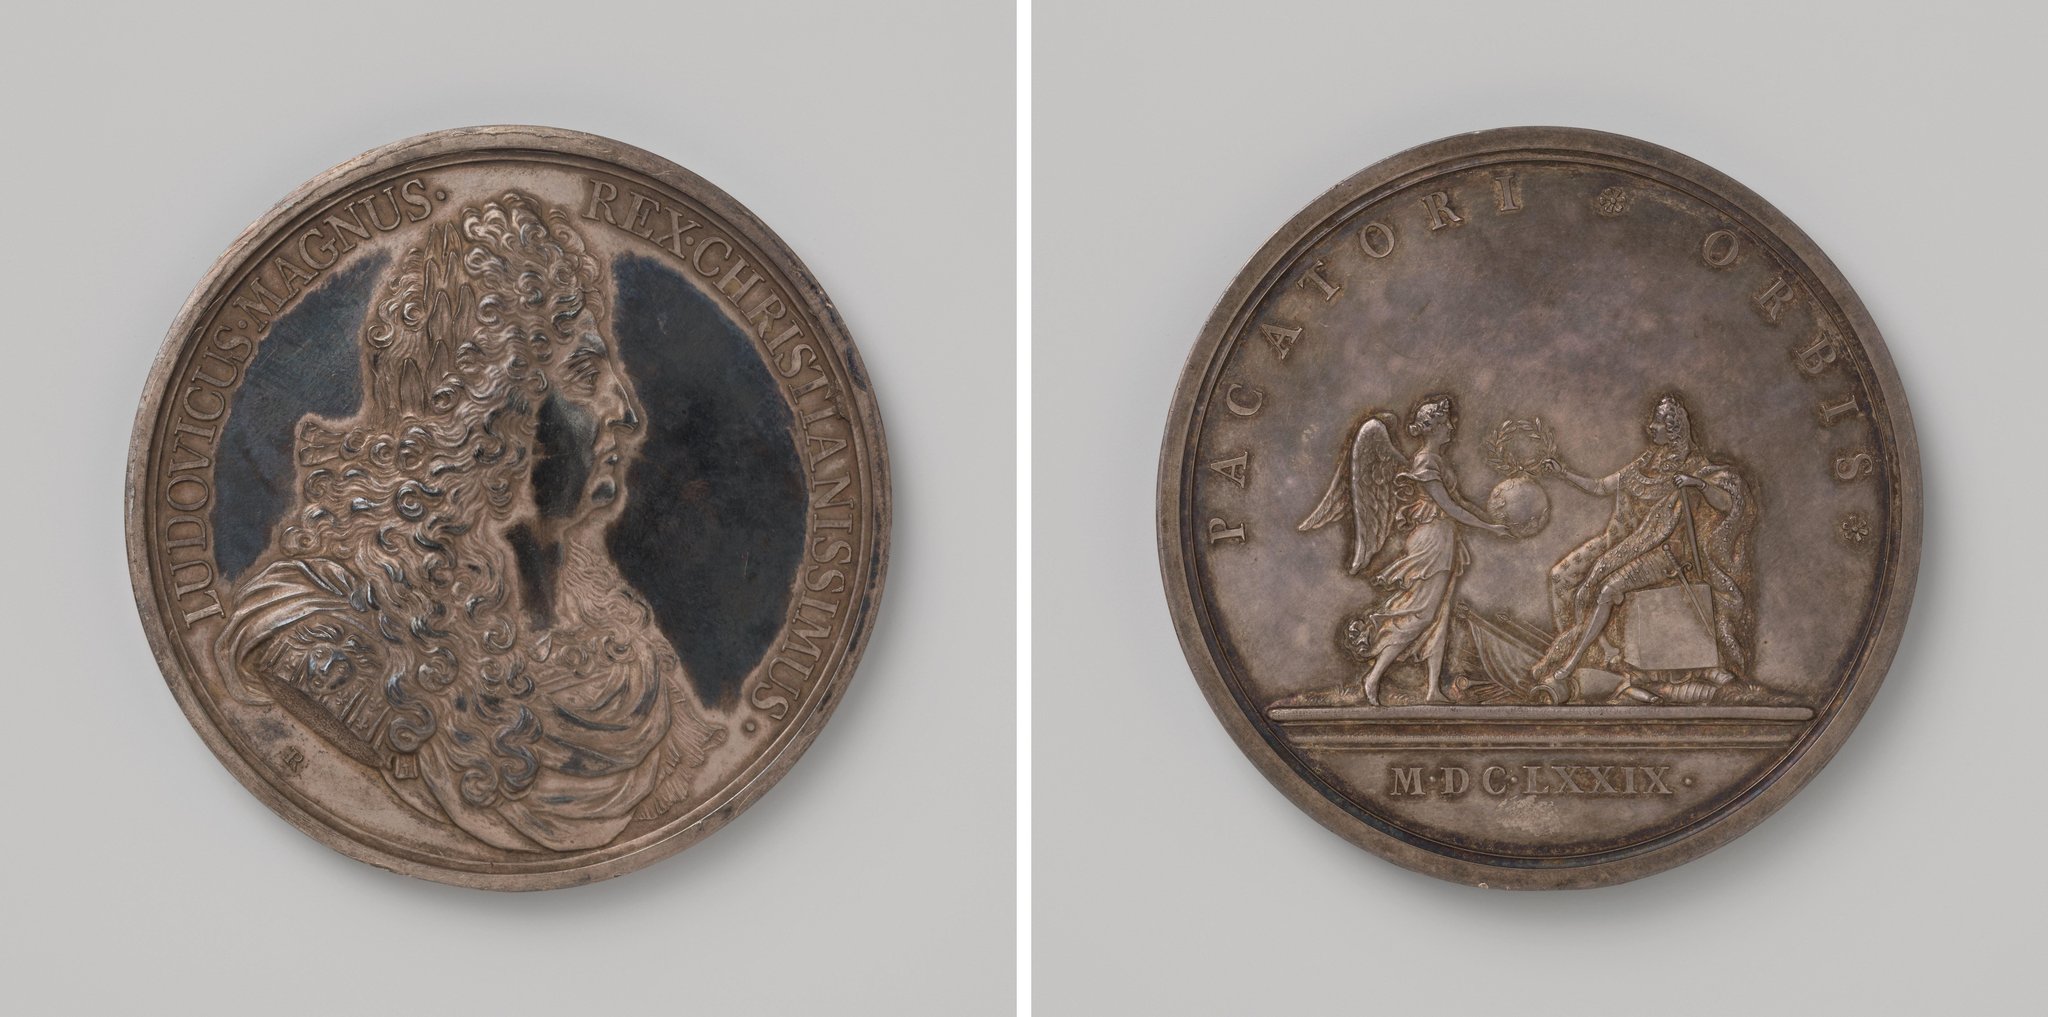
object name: history medal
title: Vrede van Nijmegen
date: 1679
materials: silver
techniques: striking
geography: france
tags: lodewijk xiv (koning van frankrijk), nijmegen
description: Zilveren penning. Voorzijde: borststuk man met lauwerkrans binnen omschrift . Keerzijde: vorst, gezeten op troon kroont wereldbol die hem door gevleugelde overwinning wordt geboden met olijvenkrans binnen omschrift; afsnede: jaartal